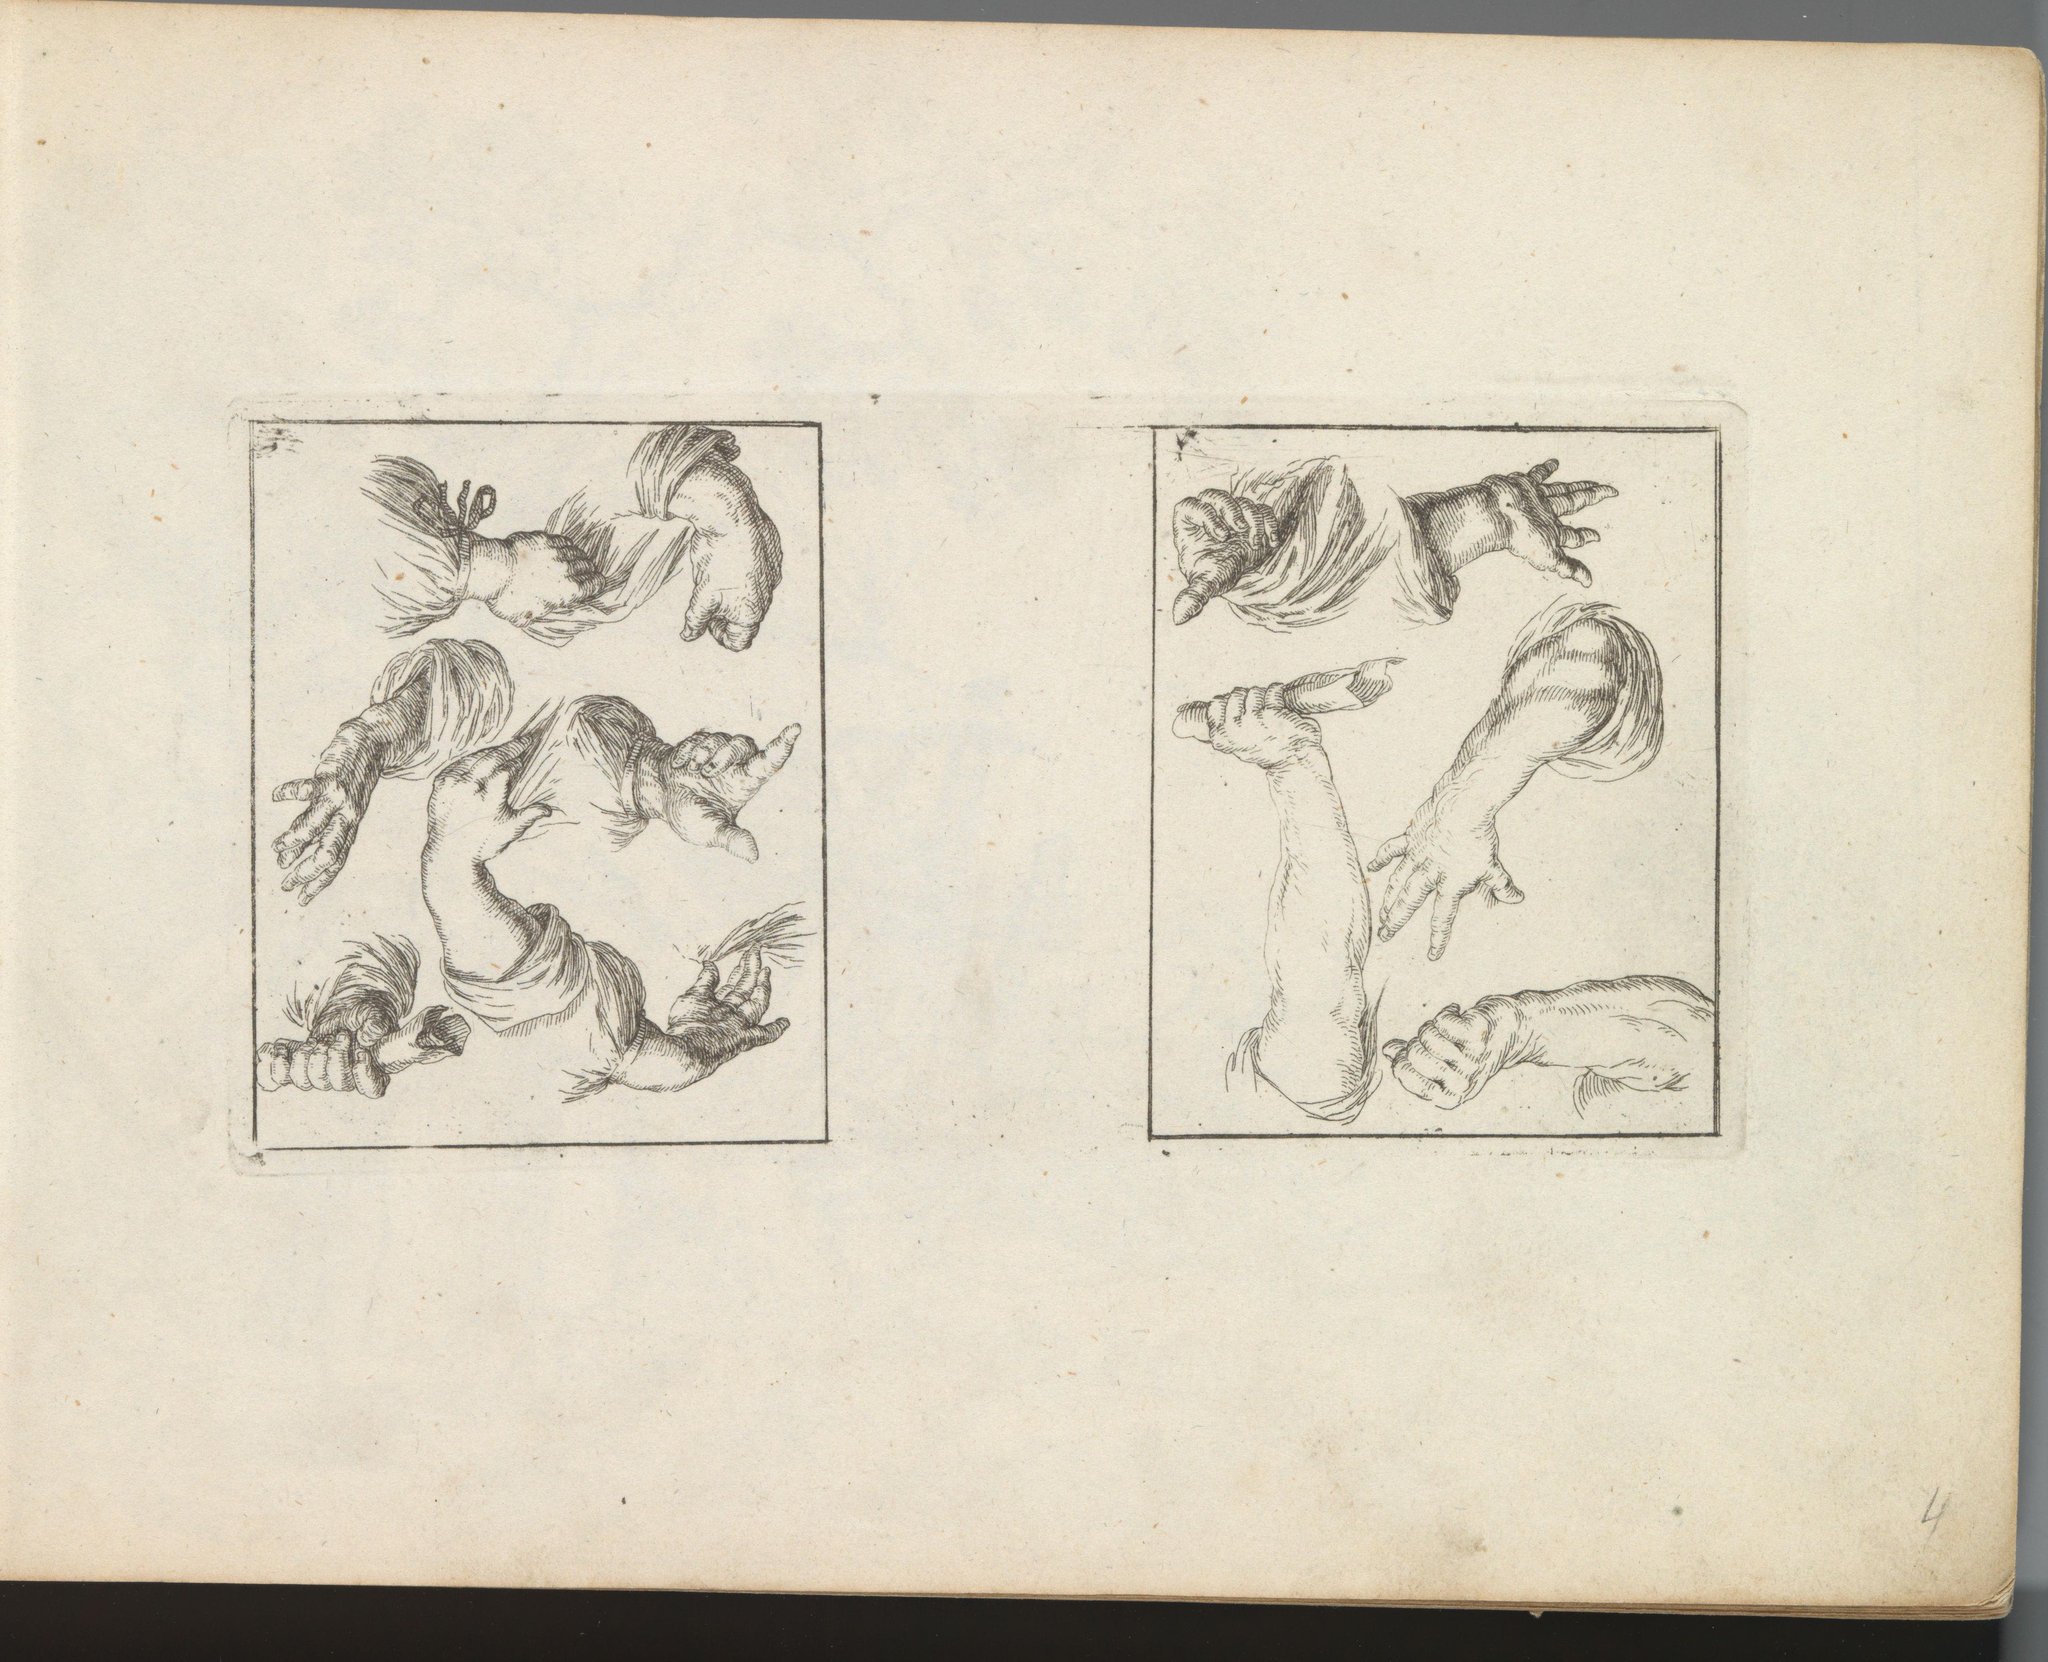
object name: album leaf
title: Spiegel der natuur en school der teekenkunde (...)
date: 1787-1833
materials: paper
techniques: etching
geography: netherlands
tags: parts of the human body (skeleton excepted), postures and gestures of hand and fingers, lower arm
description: Twee voorstellingen op een albumblad met tekenvoorbeelden van armen en handen. De prent maakt deel uit van een album.